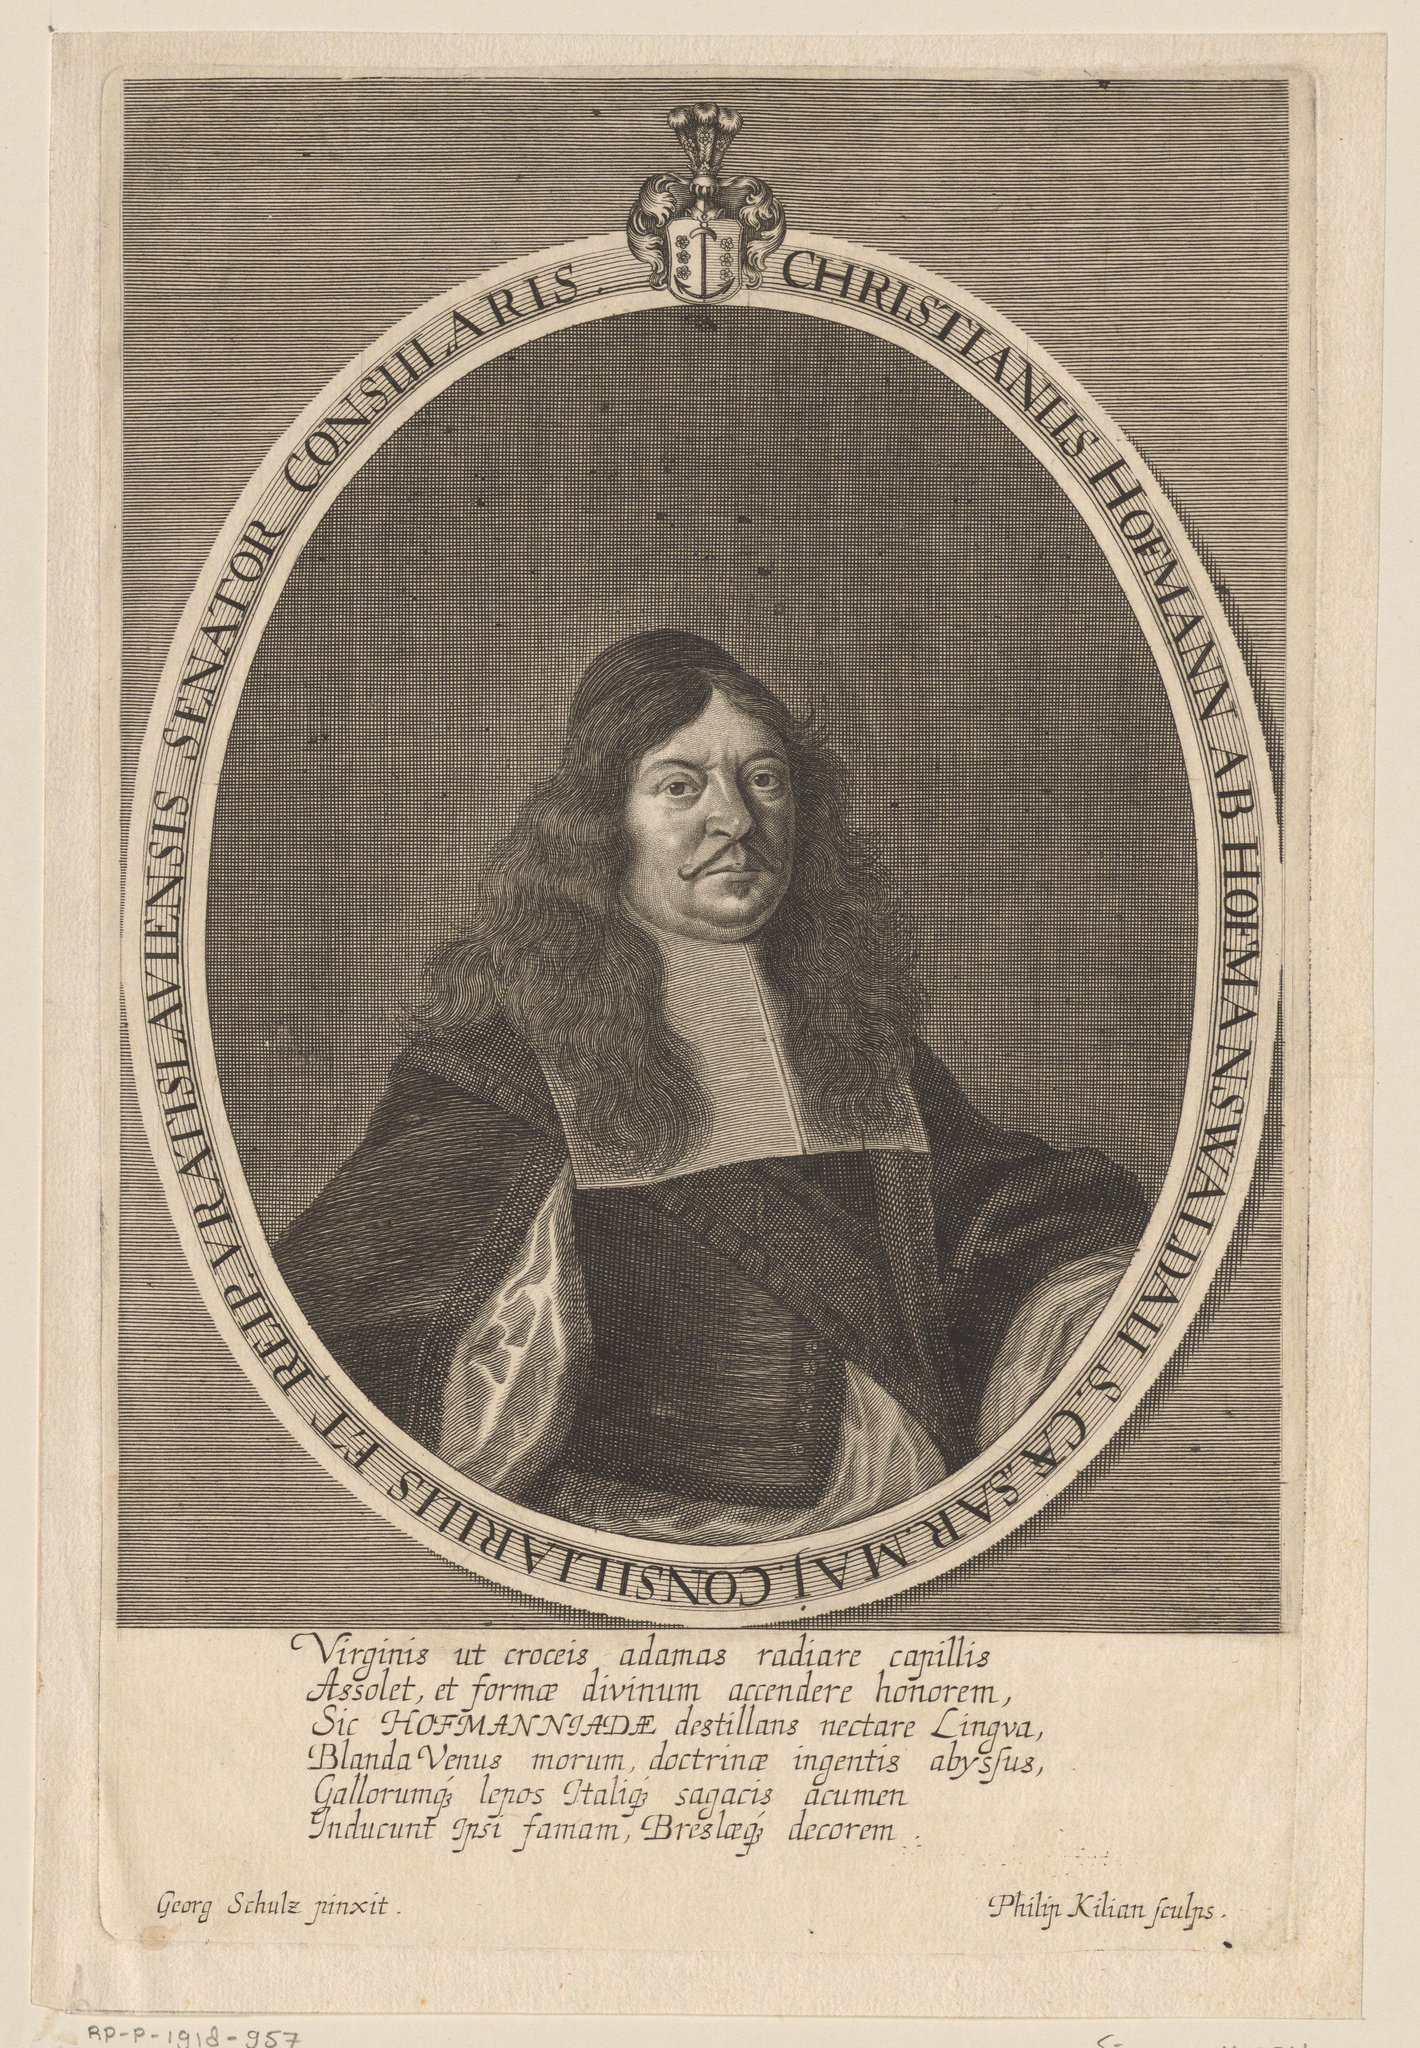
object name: print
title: Portret van Christian Hofmann von Hofmannswaldau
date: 1657-1693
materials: paper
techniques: engraving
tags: historical persons, counsellor, writer, poet, author, armorial bearing, heraldry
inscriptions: collector's mark: Lugt 2233